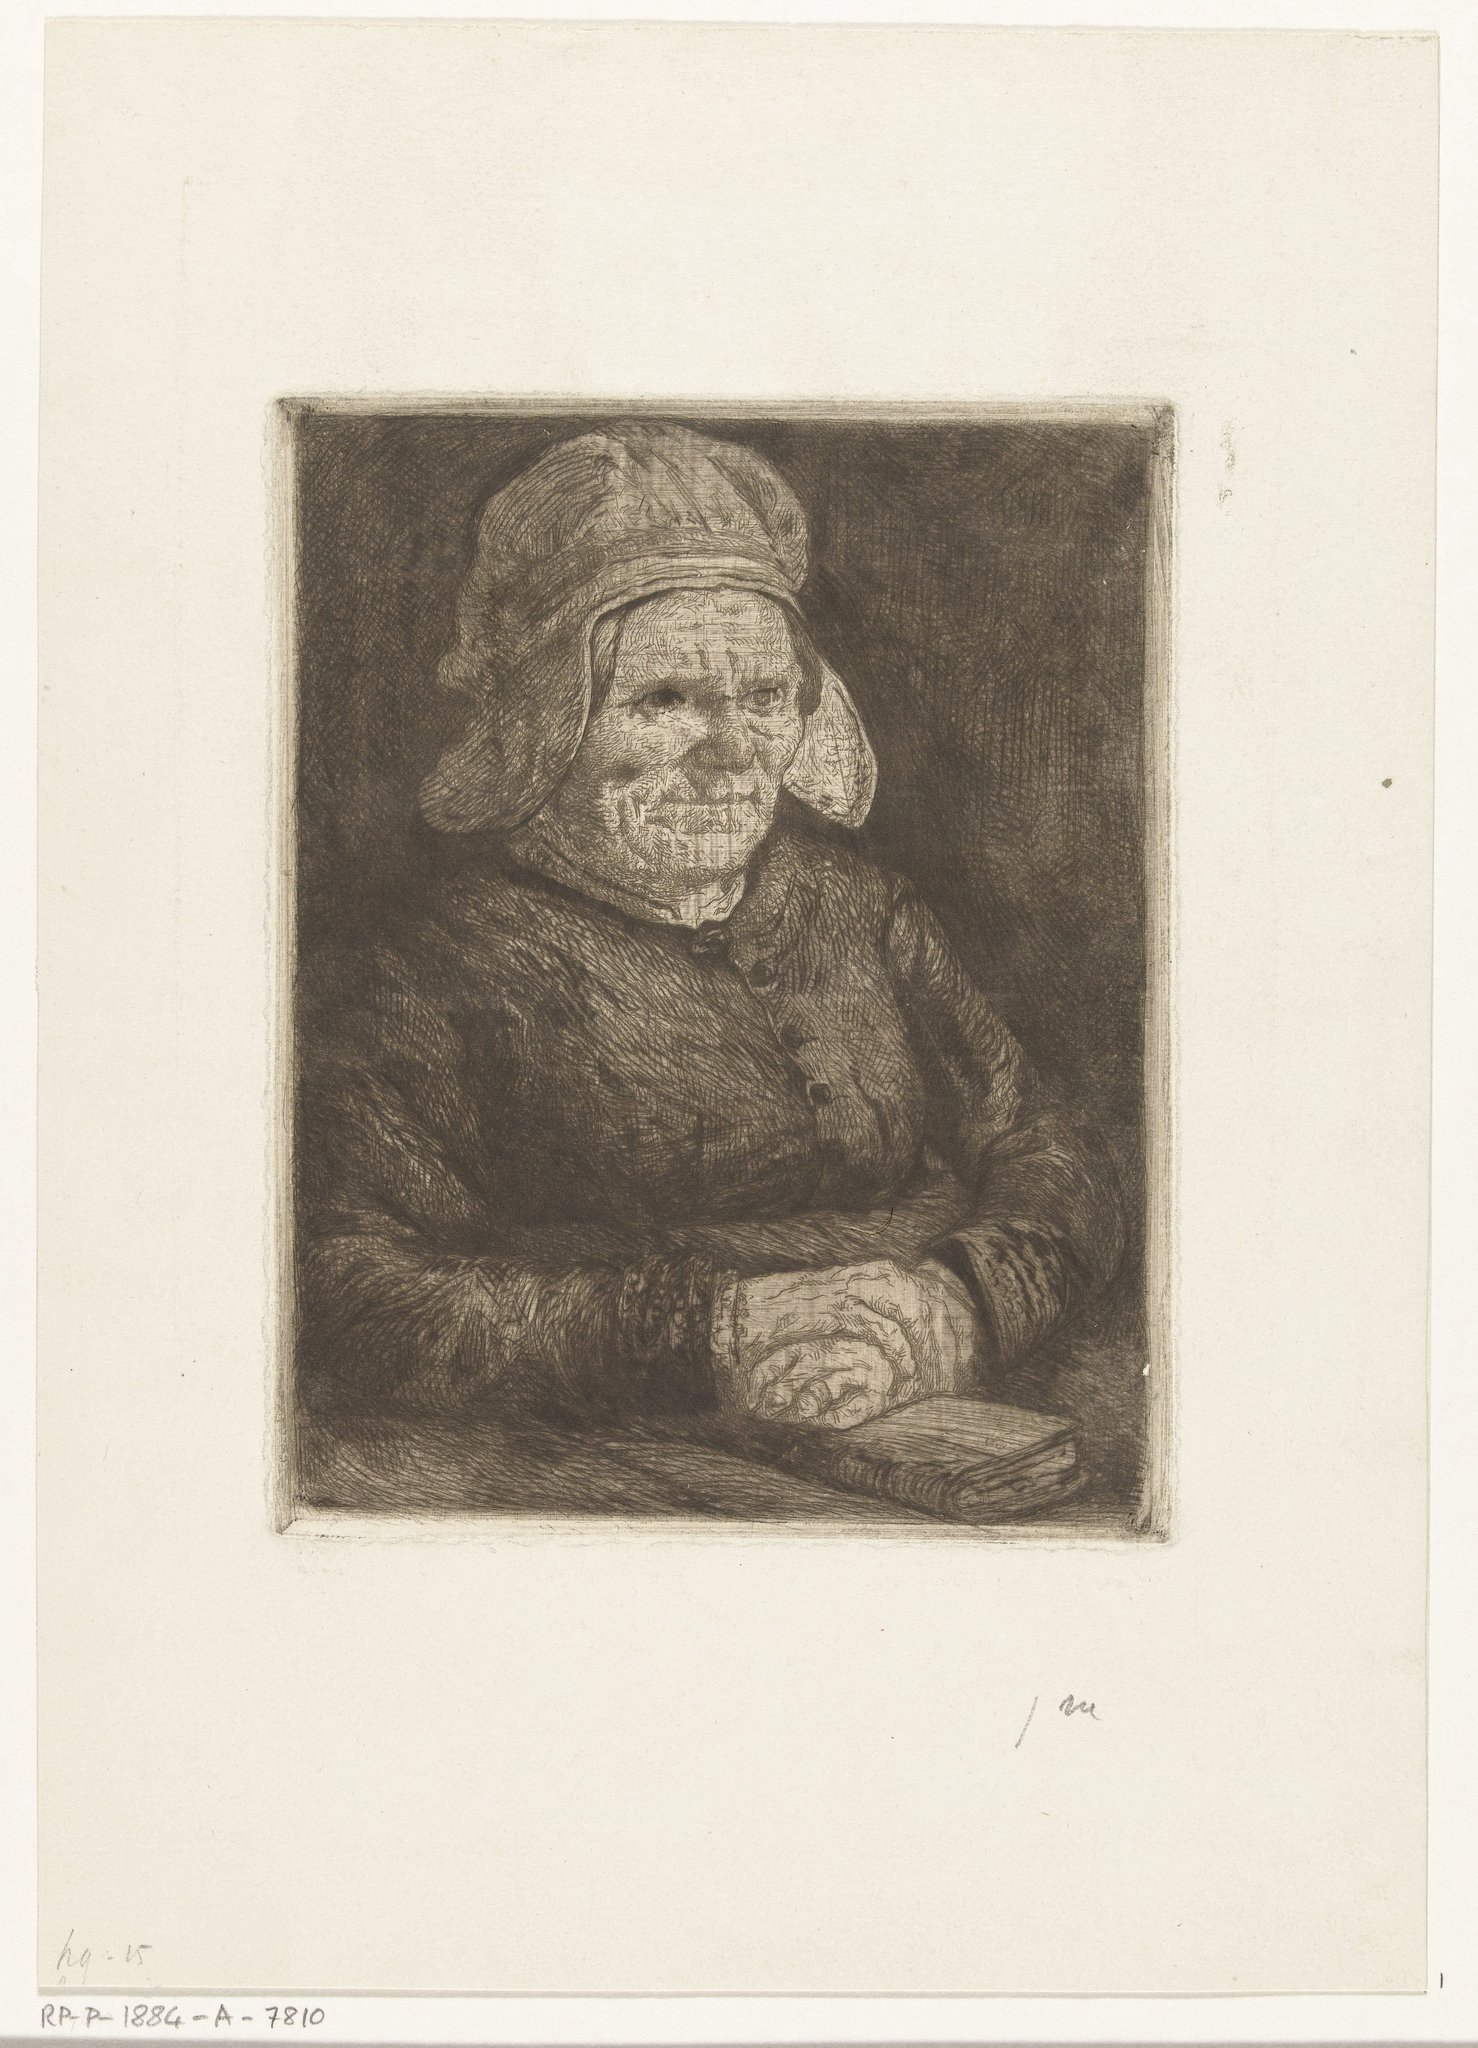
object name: print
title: Vlaams moedertje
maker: gerard jan bos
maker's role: print maker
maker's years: 1860-1943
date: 1878-1884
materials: paper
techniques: drypoint, etching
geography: antwerp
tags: head-gear: cap (+ women's clothes)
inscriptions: collector's mark: Lugt 2228